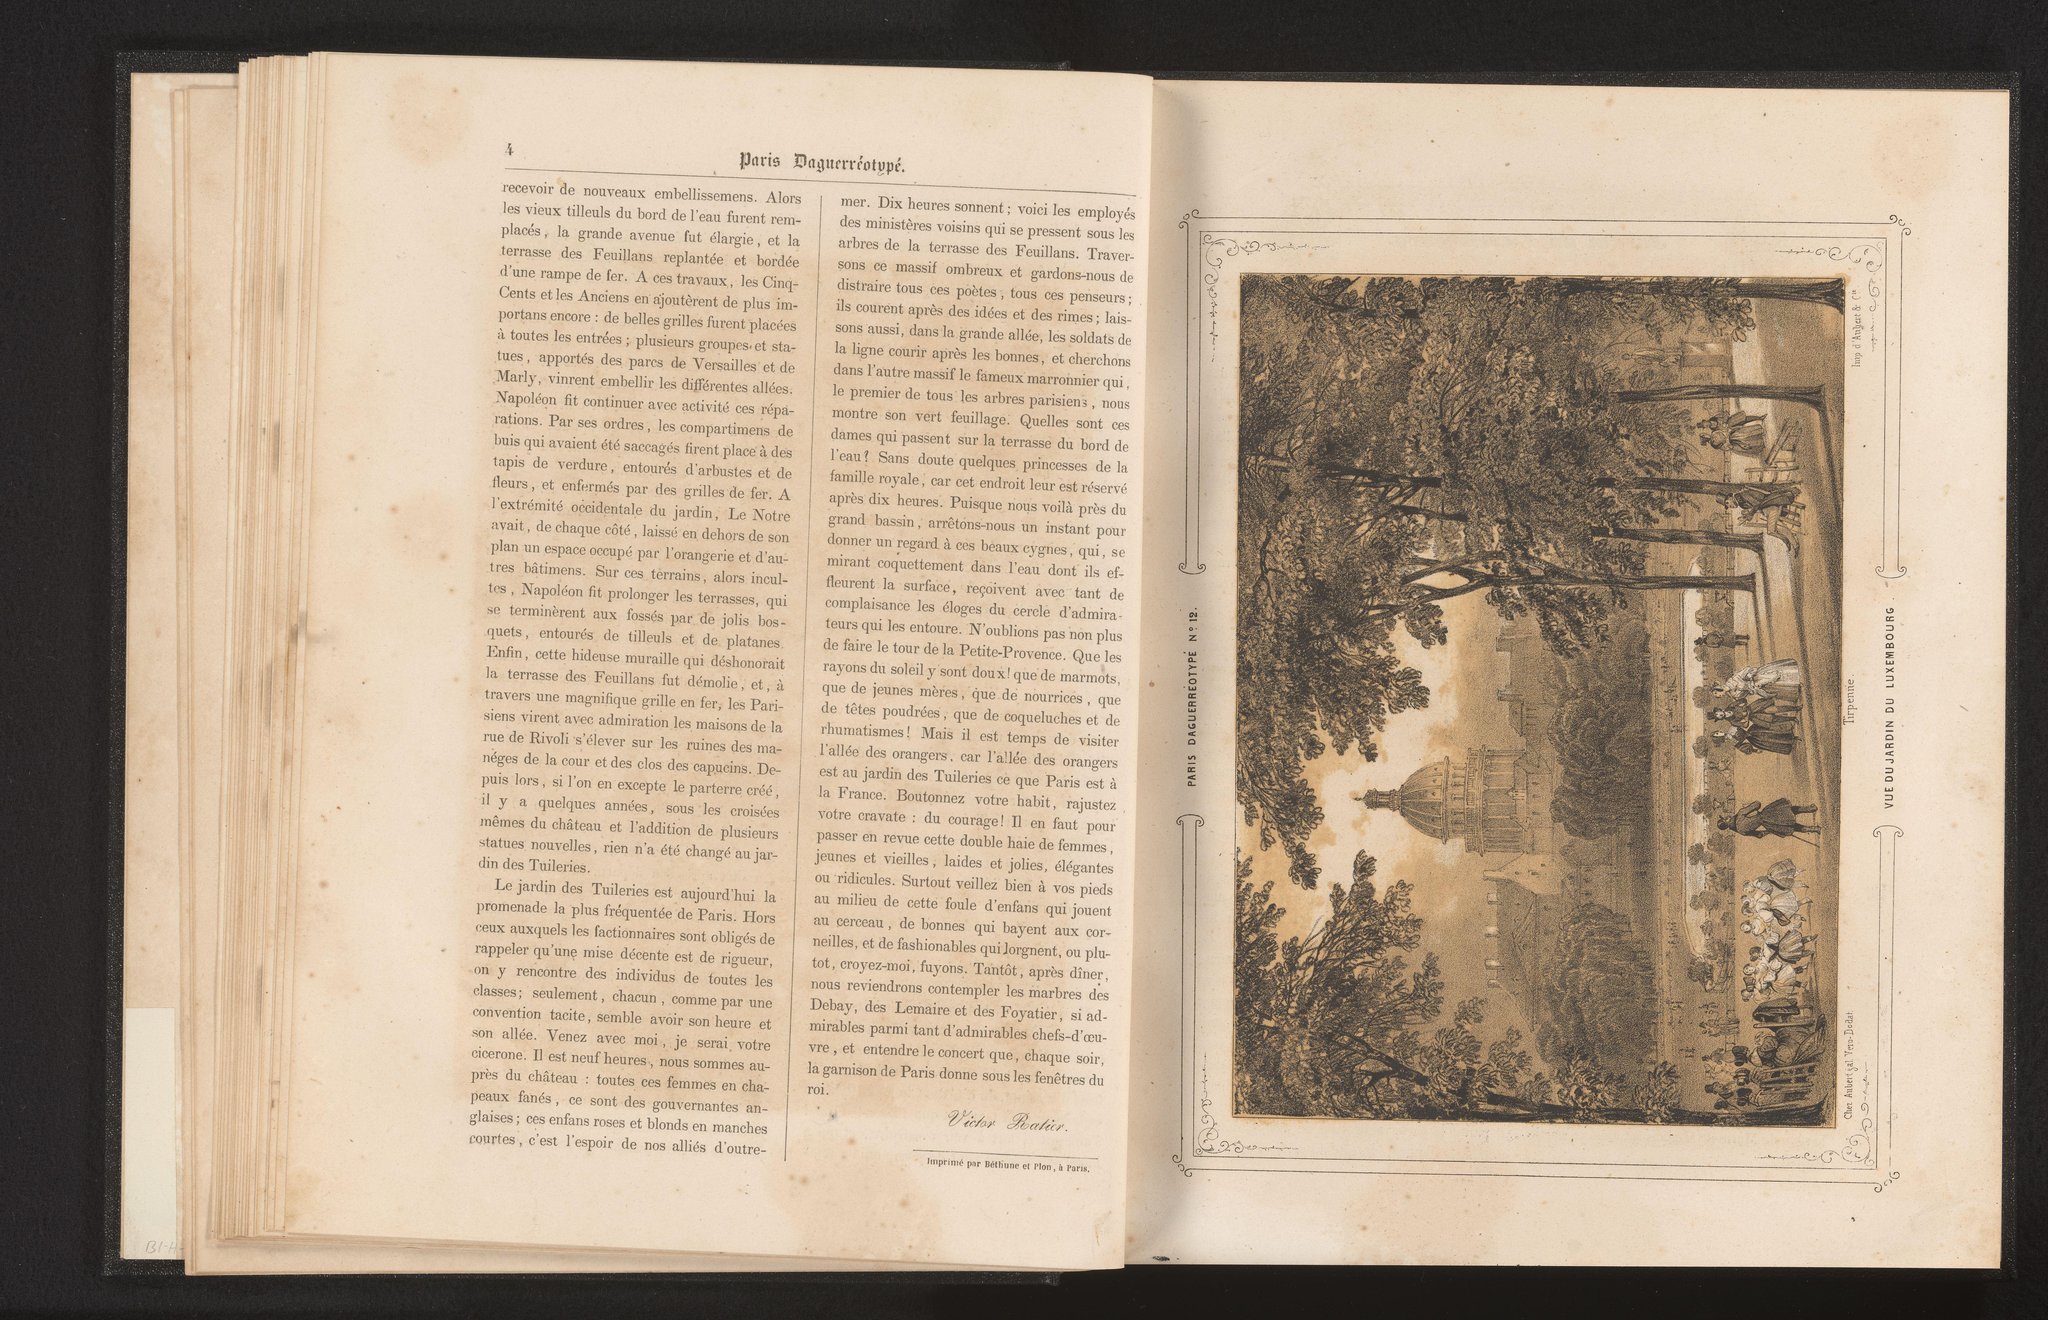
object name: page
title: Jardin du Luxembourg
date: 1839-1840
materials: paper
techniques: tone lithography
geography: paris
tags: park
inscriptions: inscription: ‘PARIS DAGUERRÉOTYPÉ No. 12.’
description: Prent op vijfenveertigste ongenummerde pagina.